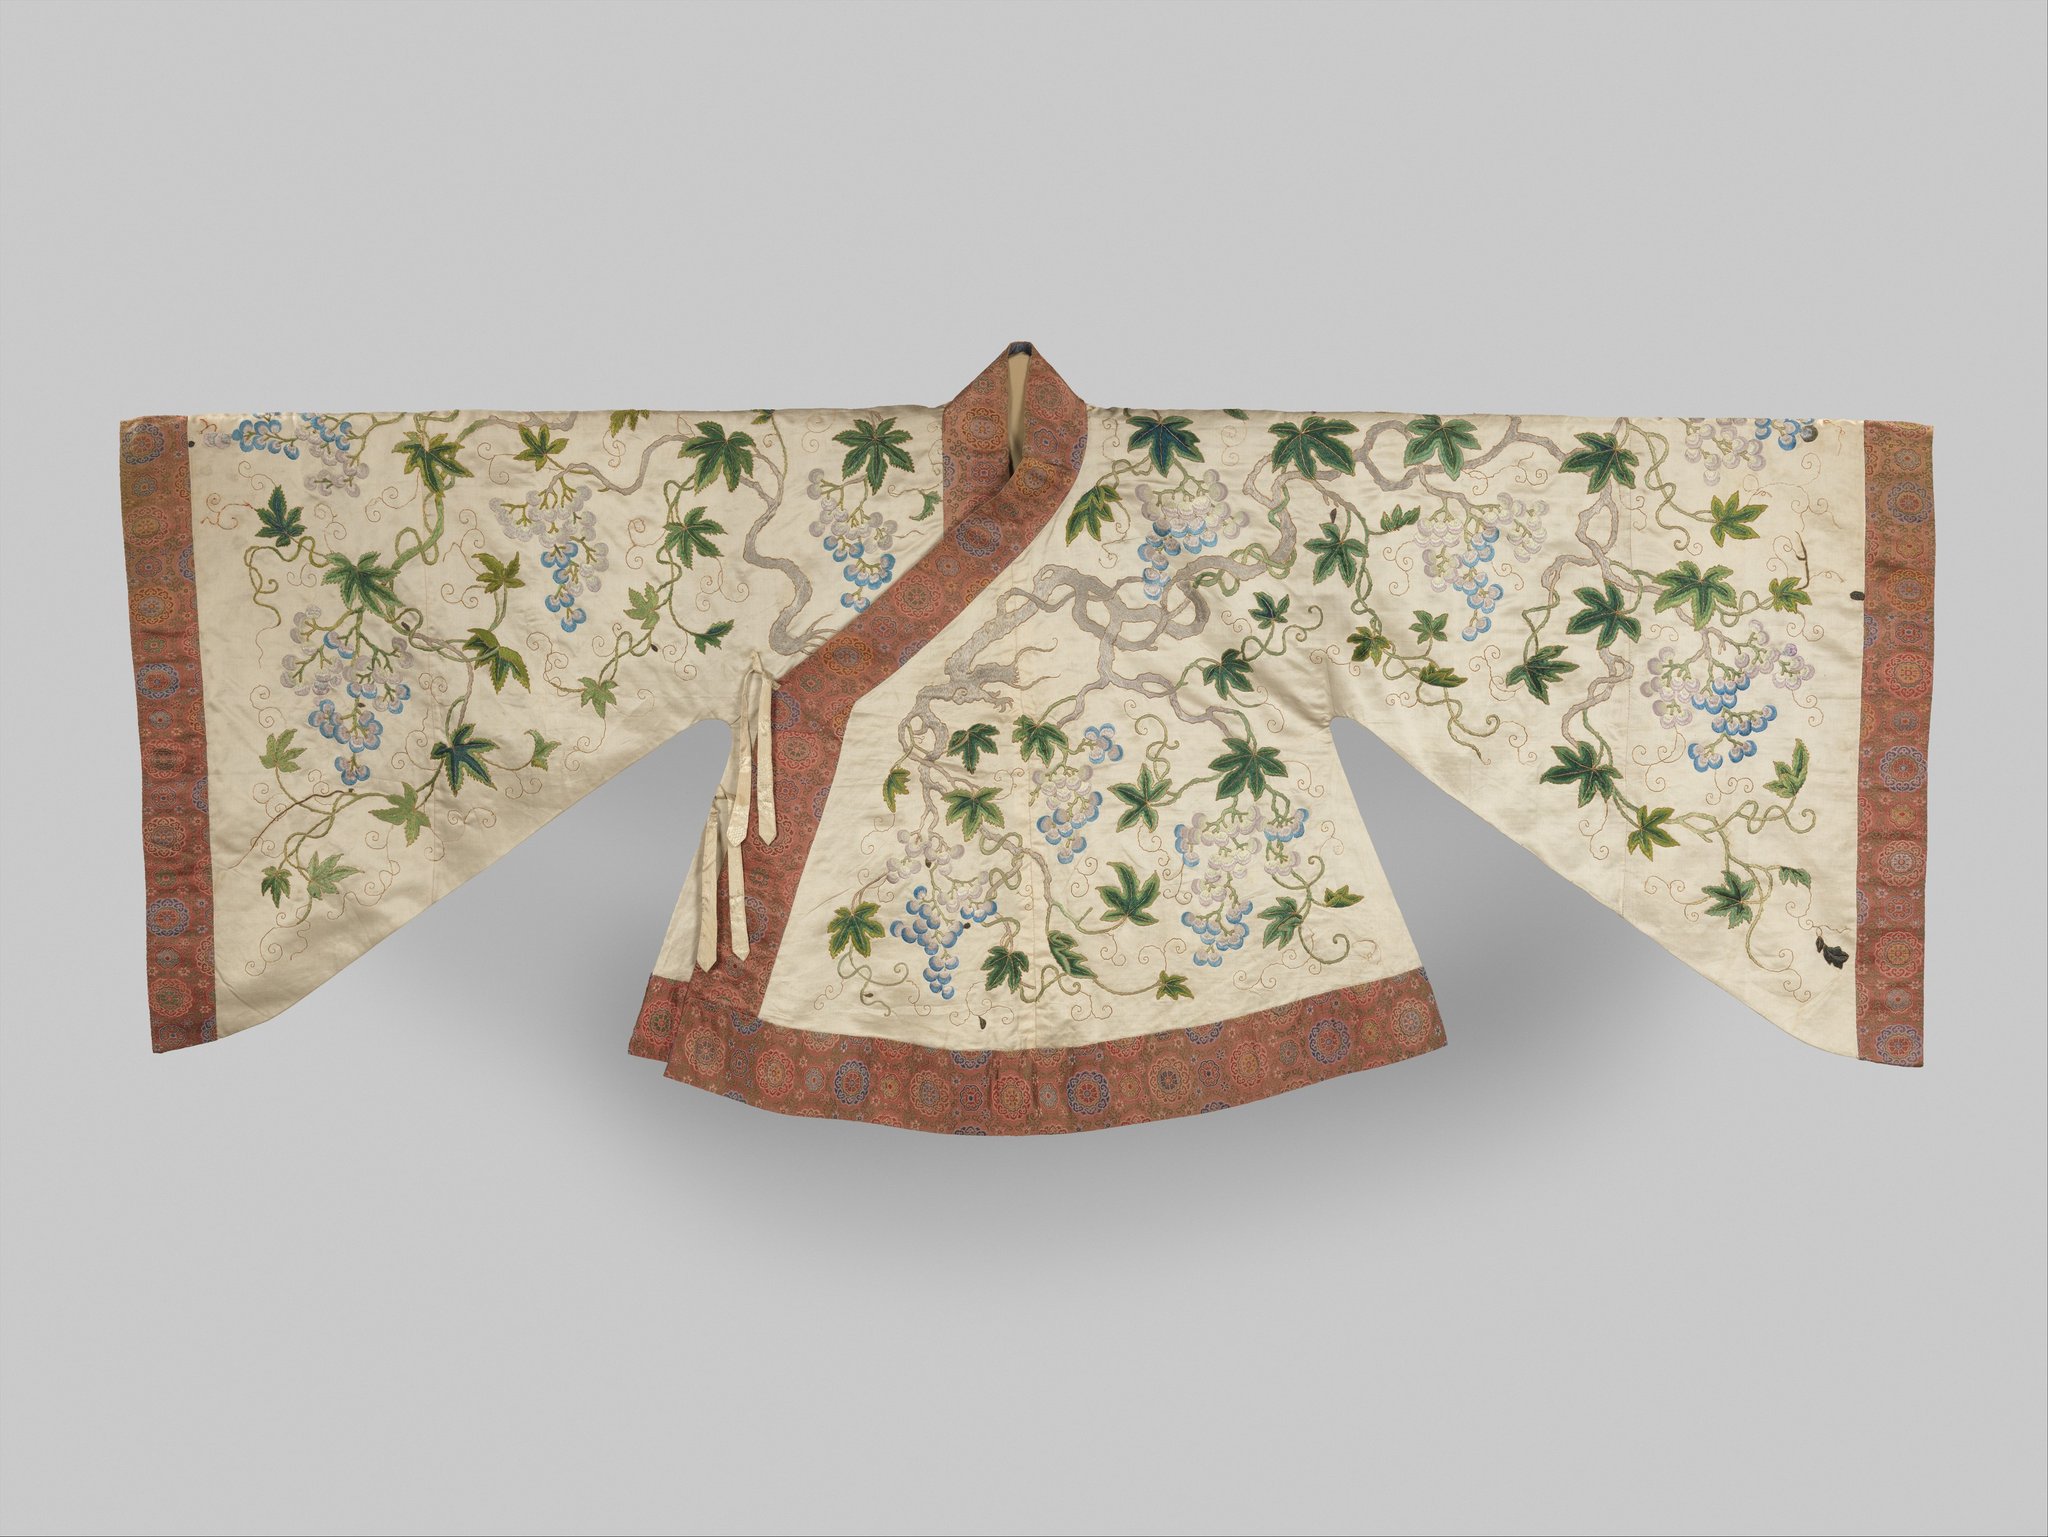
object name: jacket, imperial theatrical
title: Theatrical jacket with grapevines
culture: chinese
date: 1701-1800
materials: metal thread, silk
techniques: brocade, embroidery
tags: grapes,dragons